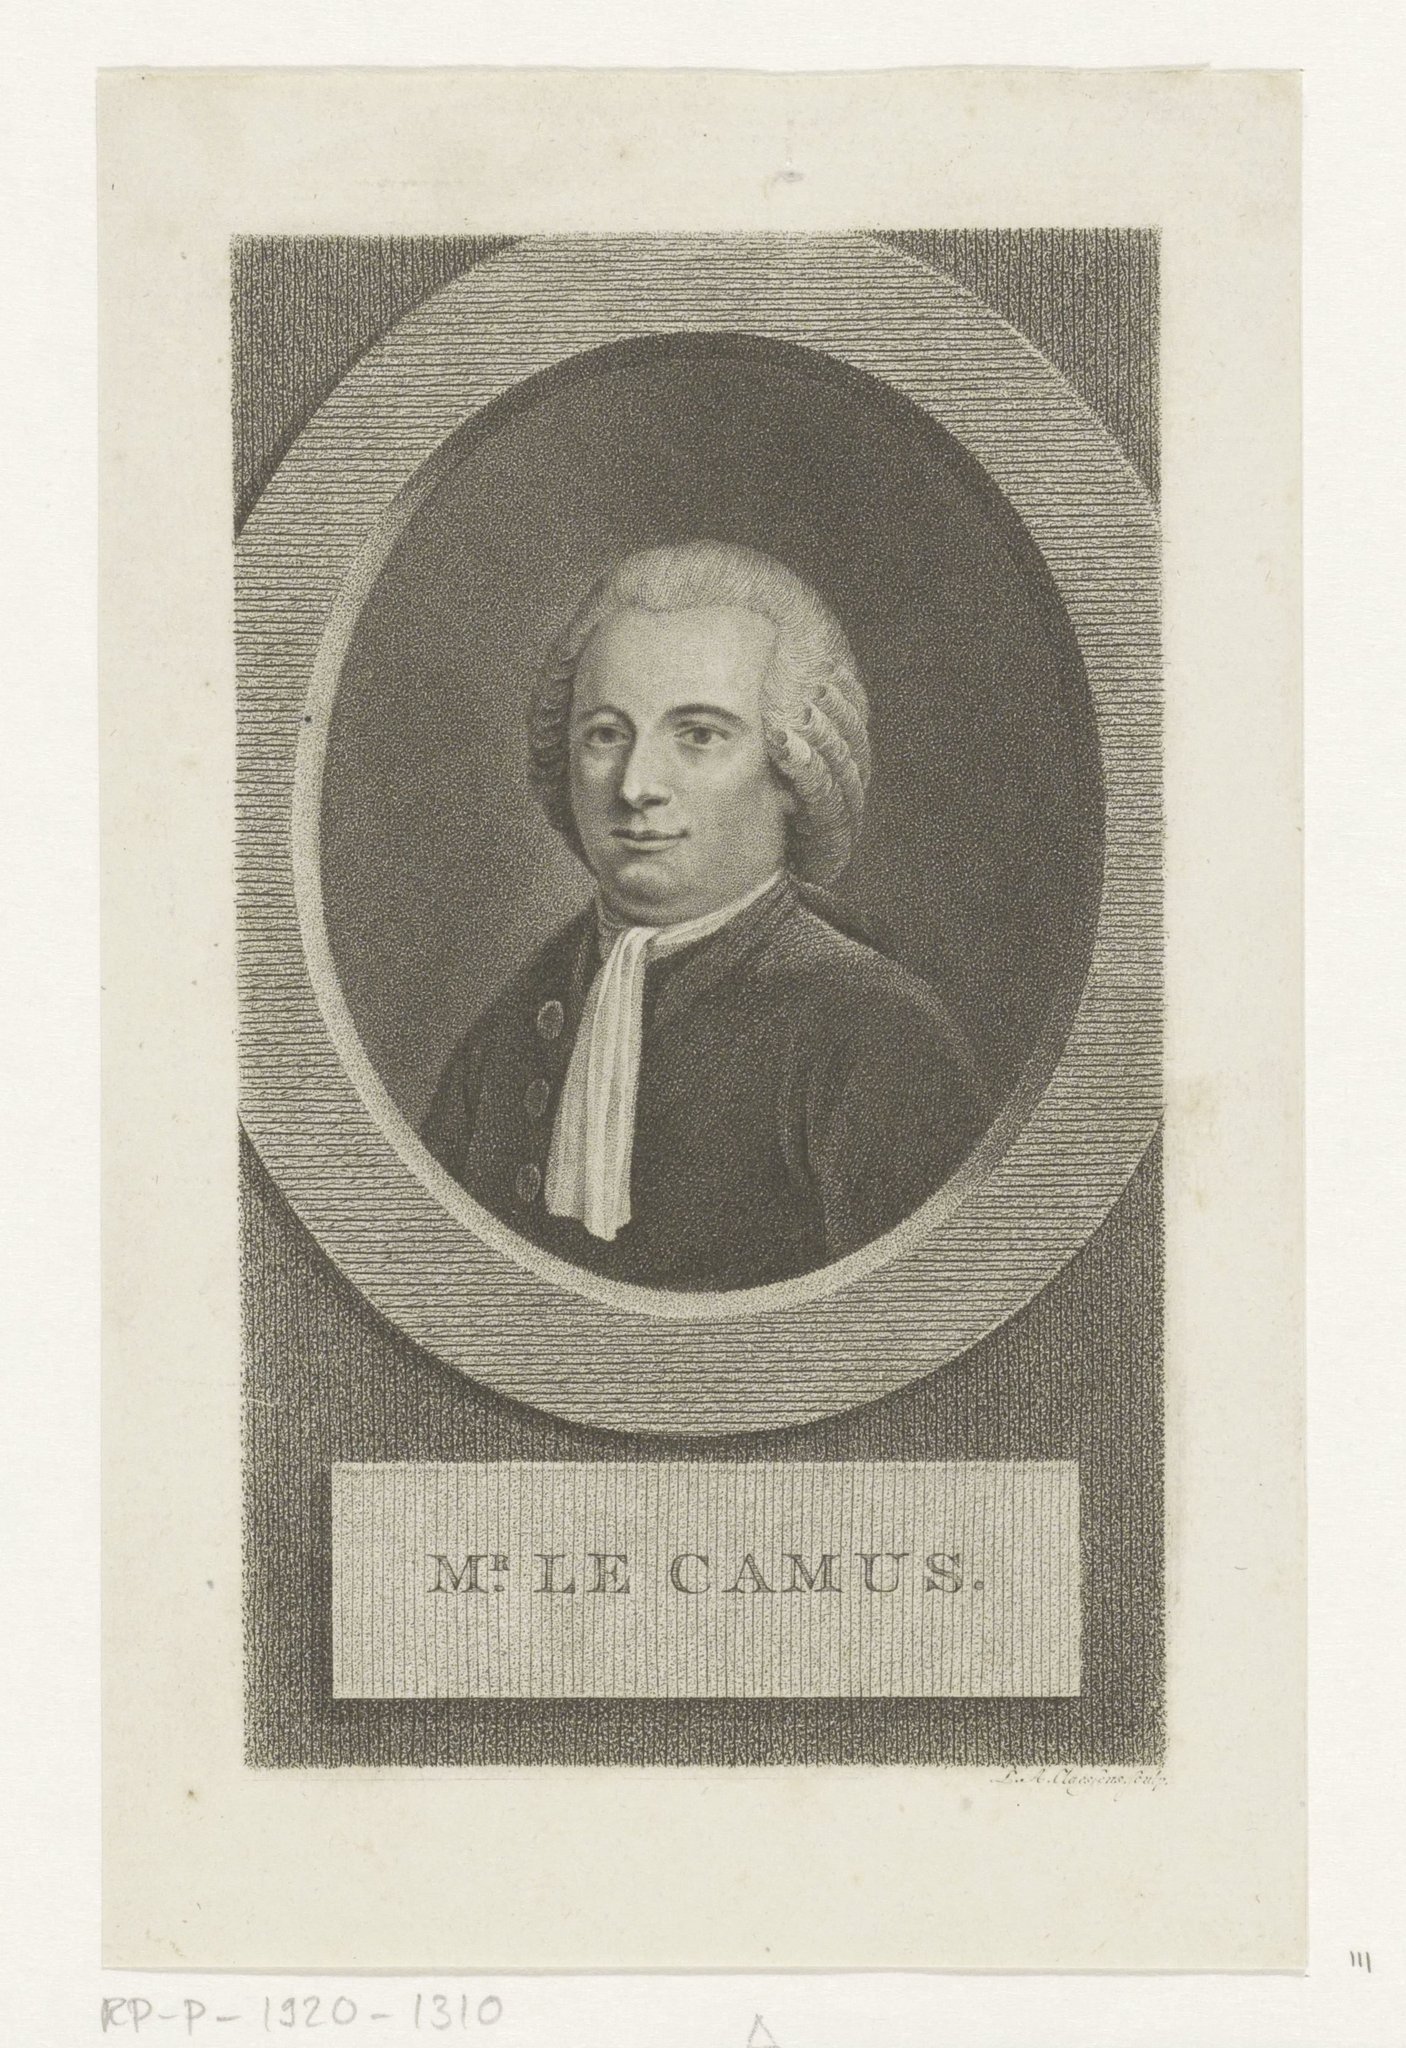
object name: print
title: Portret van Armand Gaston Camus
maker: lambertus antonius claessens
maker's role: draughtsman, print maker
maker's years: 1763-1834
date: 1792-1808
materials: paper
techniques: engraving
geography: amsterdam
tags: jurist, armand gaston camus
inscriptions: collector's mark: Lugt 2228